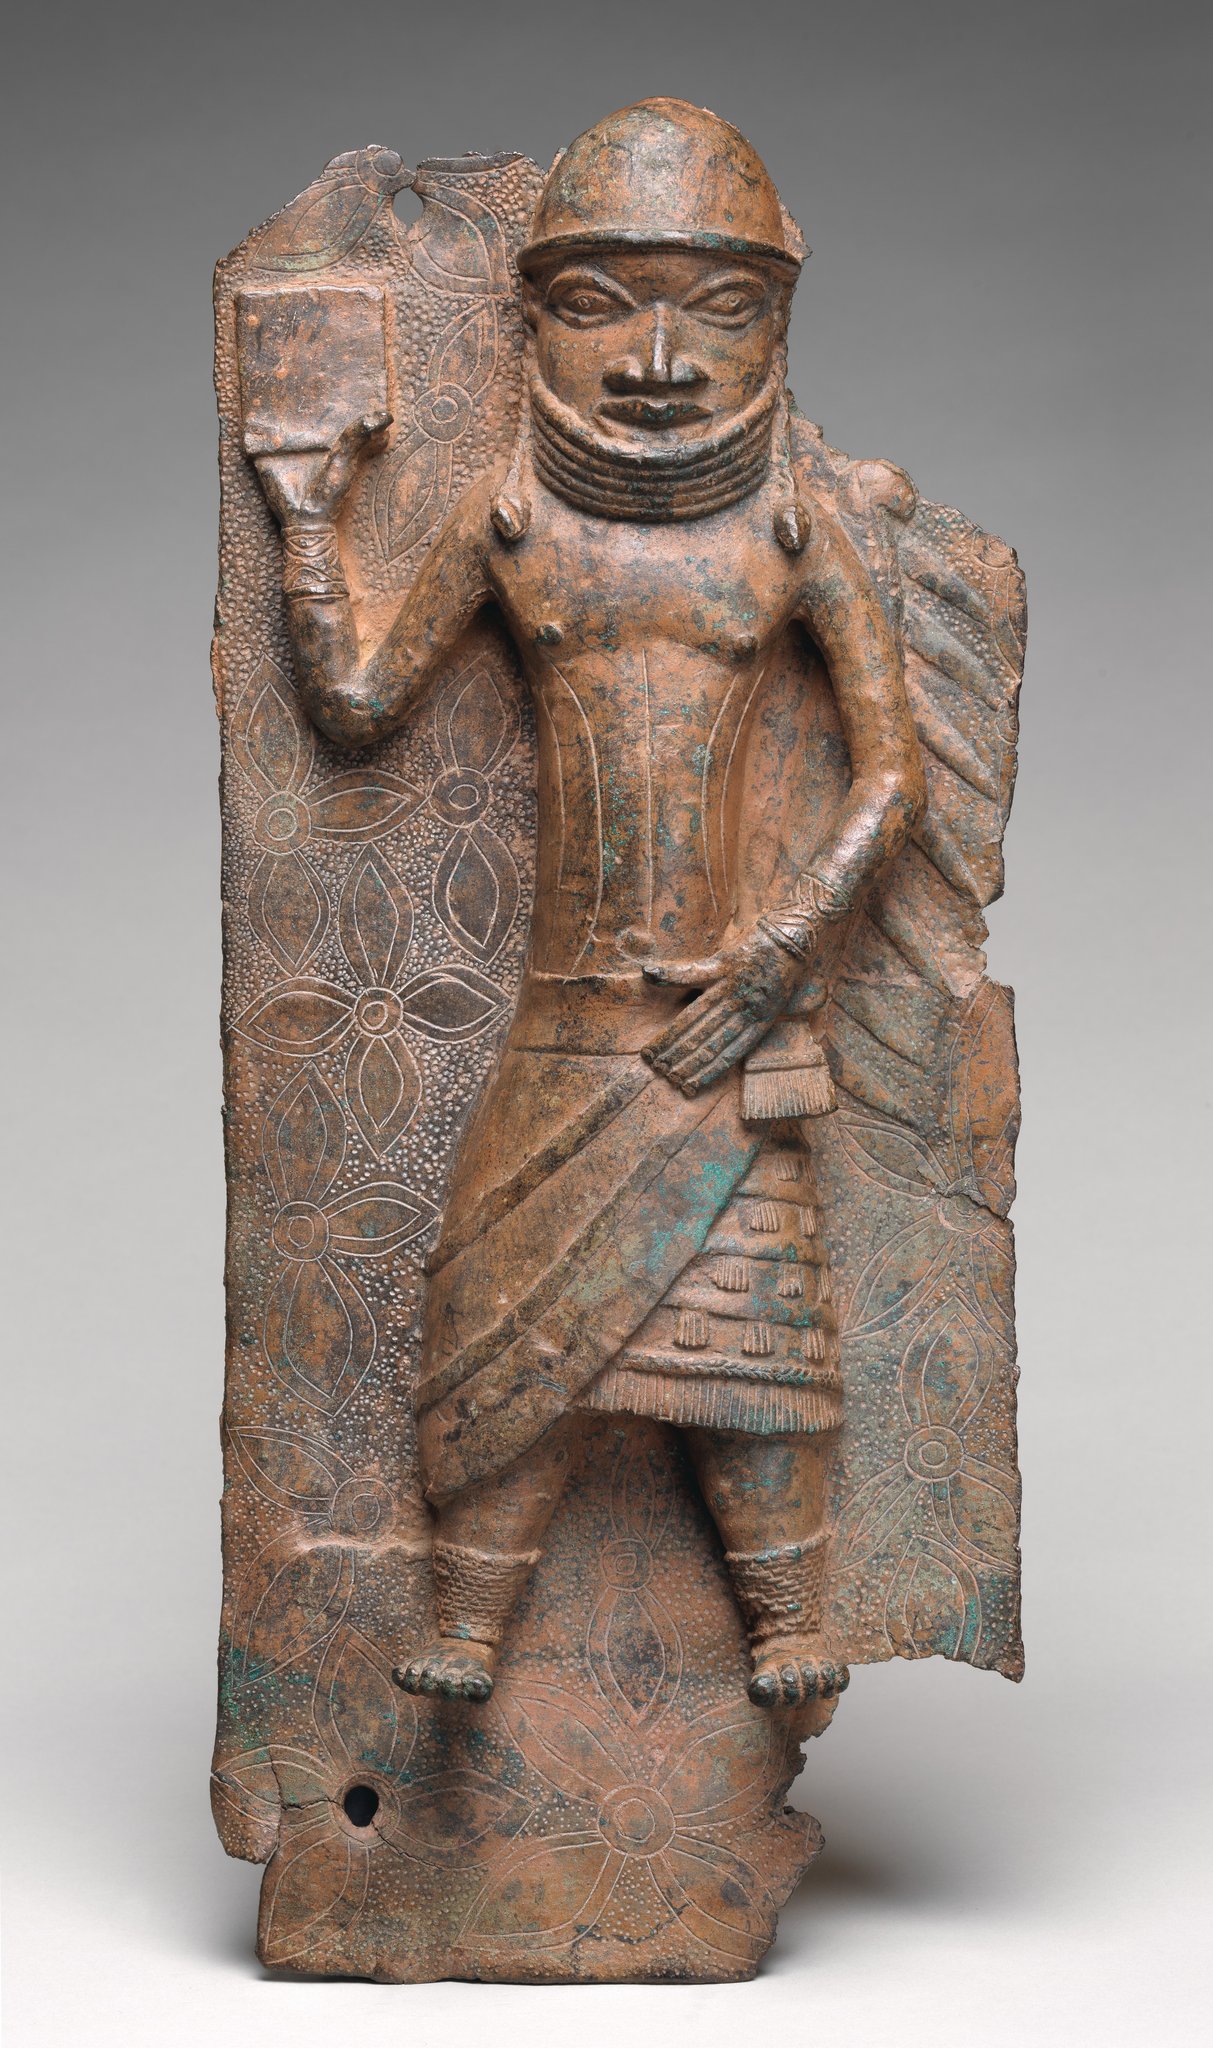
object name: plaque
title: Plaque with Court Official Holding a Protective Amulet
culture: edo period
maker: ìgùn ẹ́rọ̀nwwọ̀n (brass-casting guild) artists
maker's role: artist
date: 1540-1570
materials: brass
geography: nigeria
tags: men